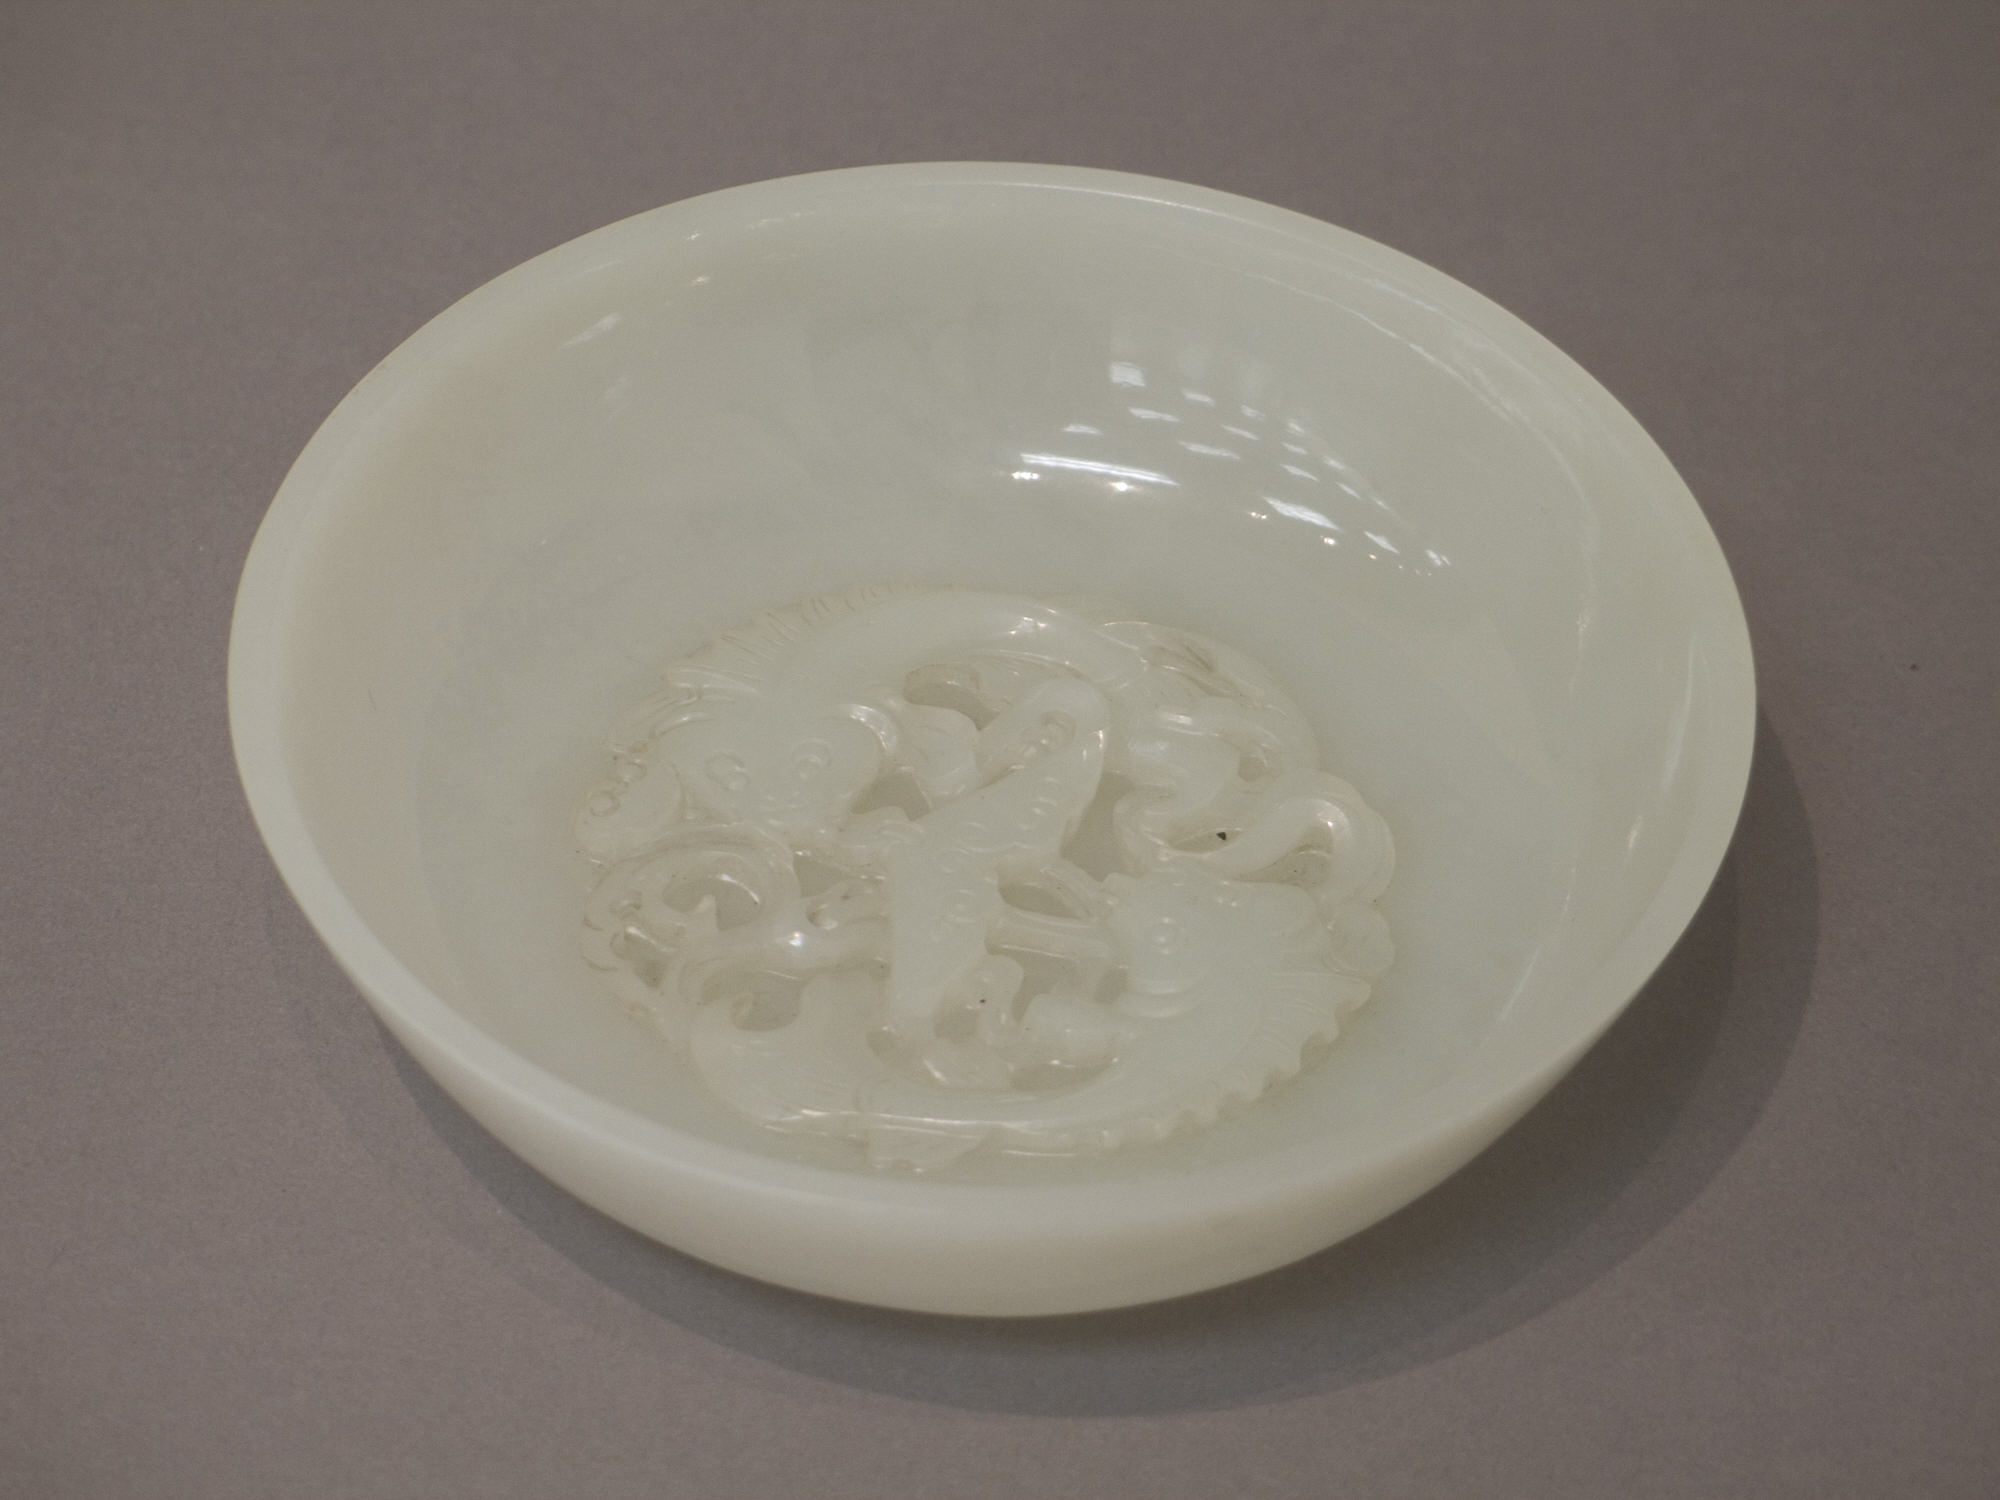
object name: dish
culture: chinese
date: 1736-1795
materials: jade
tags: fish